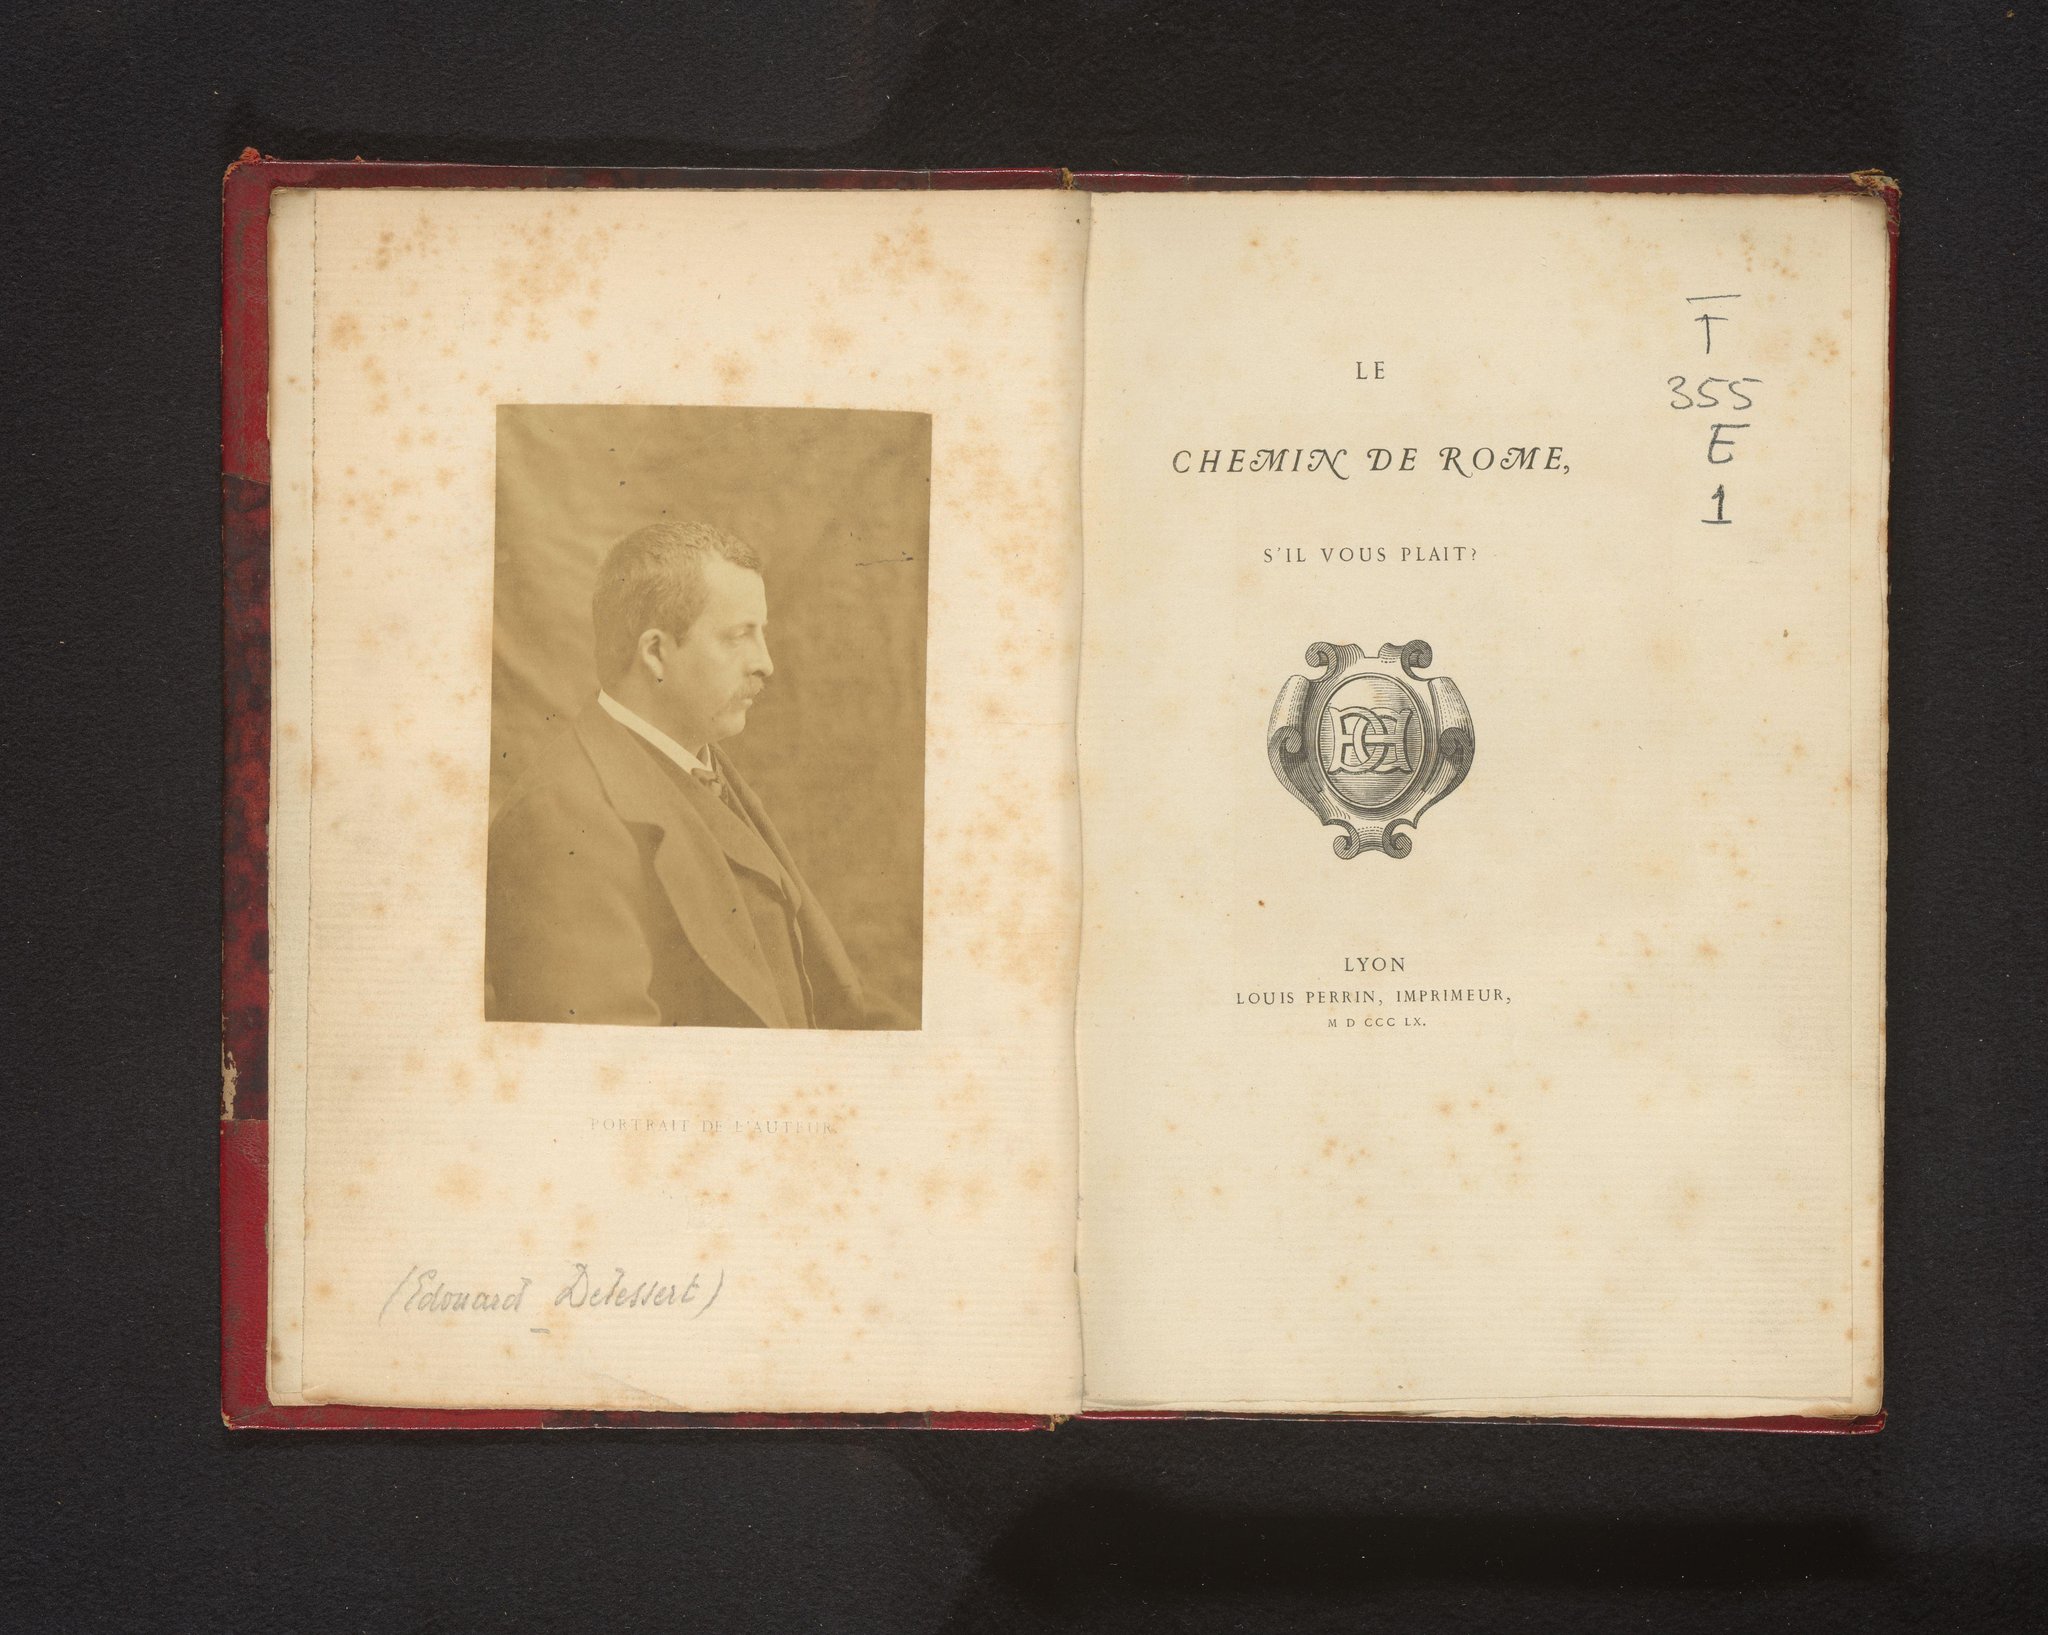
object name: book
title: Le chemin de Rome s'il vous plait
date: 1860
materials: cardboard, leather, paper, photographic support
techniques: marbled paper, albumen print, decorated paper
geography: lyon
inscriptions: bookplate: ‘Nemp Al Arid’